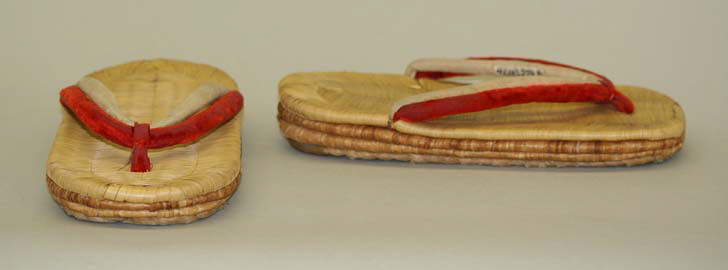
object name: zori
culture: japanese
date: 1800-1941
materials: fiber